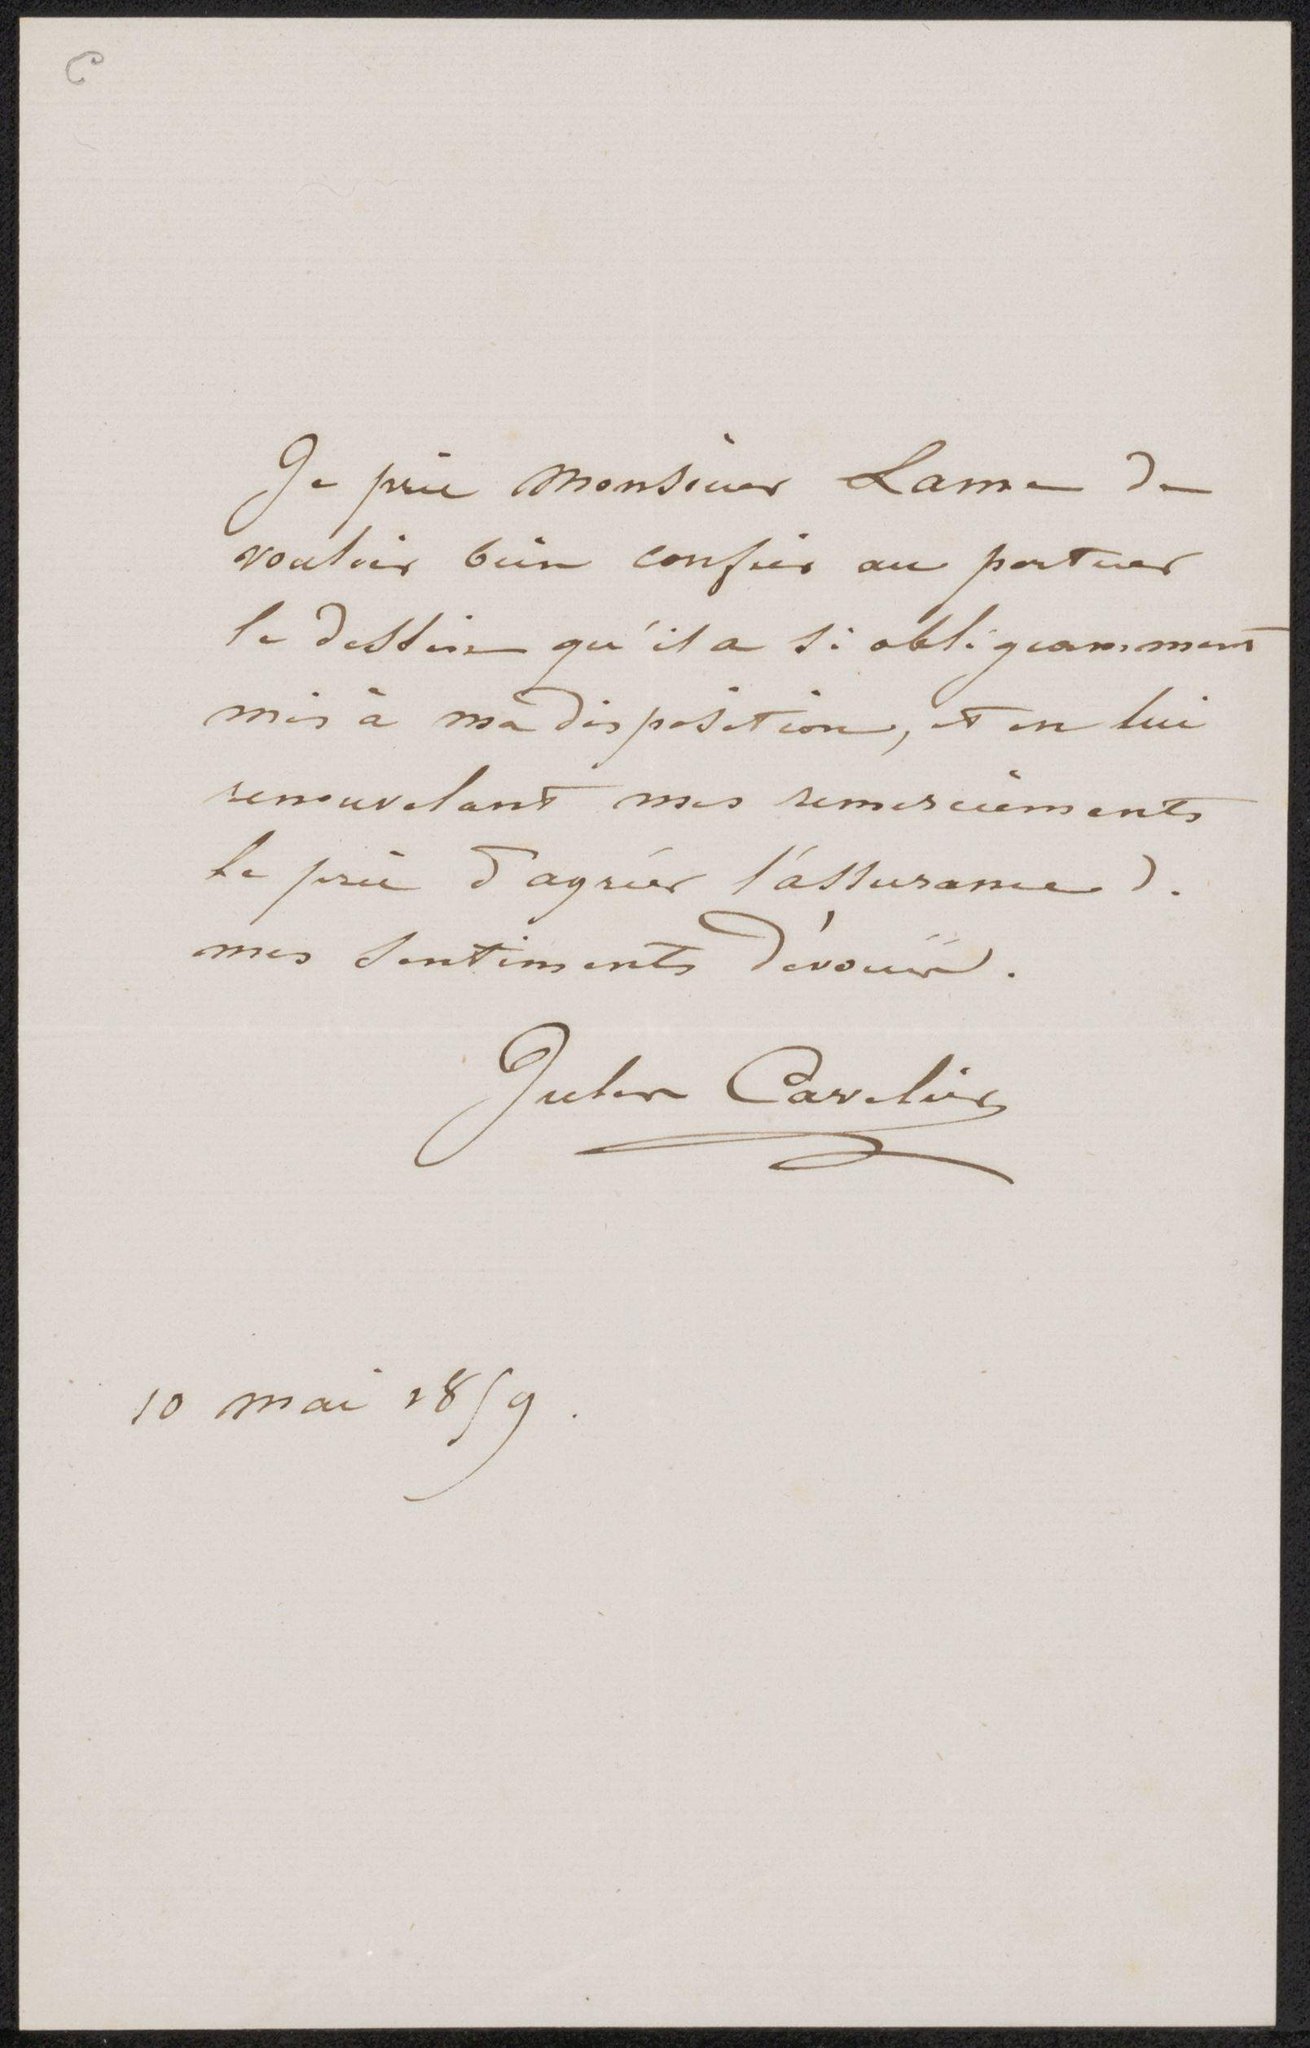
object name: letter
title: Brief aan Ary Johannes Lamme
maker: pierre jules cavelier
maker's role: sculptor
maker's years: 1814-1894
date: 1859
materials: ink, paper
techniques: pen, writing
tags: dordrecht, print maker, draughtsman, ary johannes lamme, drawing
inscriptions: collector's mark: Lugt 2228